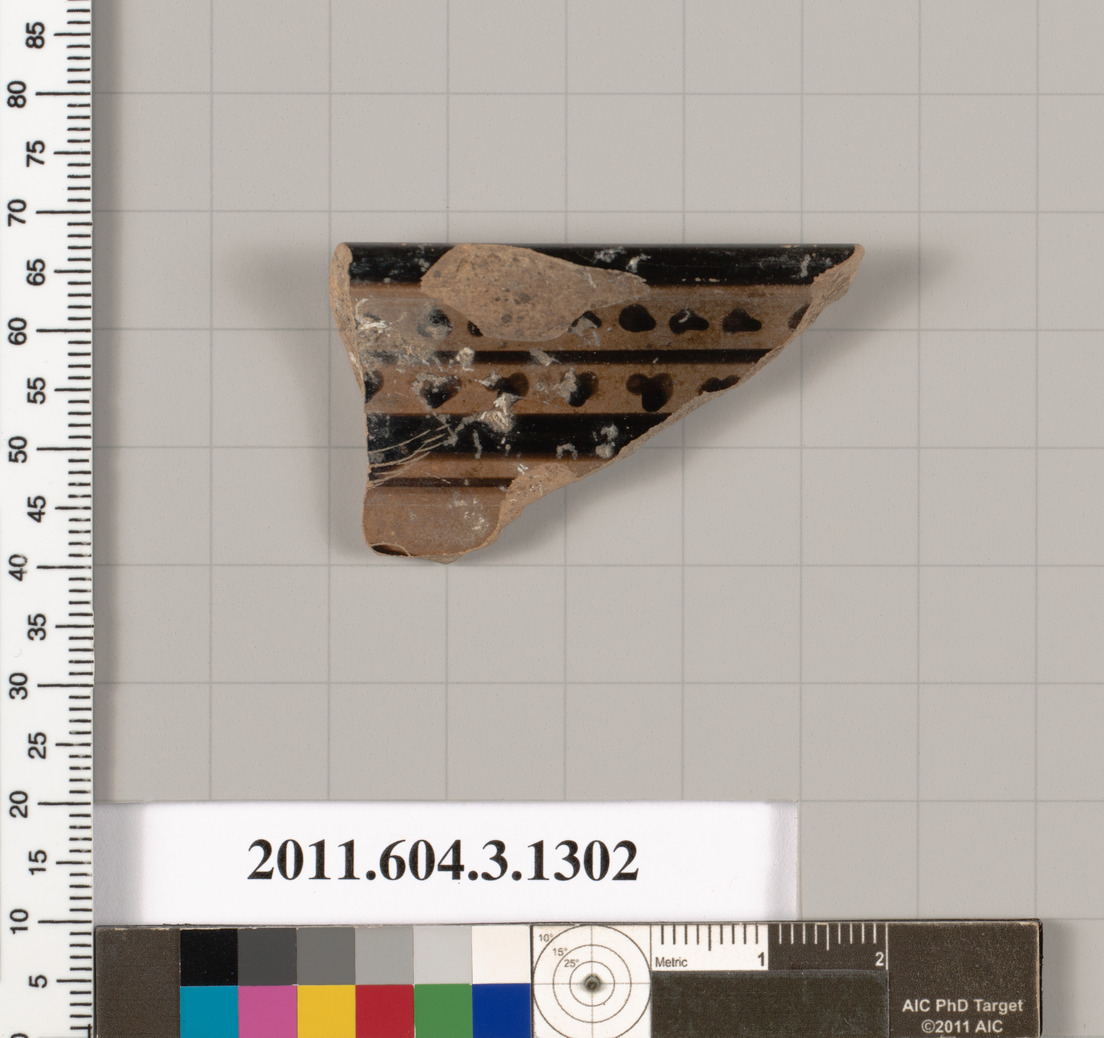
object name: skyphos fragment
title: Terracotta rim fragment of a skyphos (deep drinking cup)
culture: greek, attic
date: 534-468 BCE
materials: terracotta